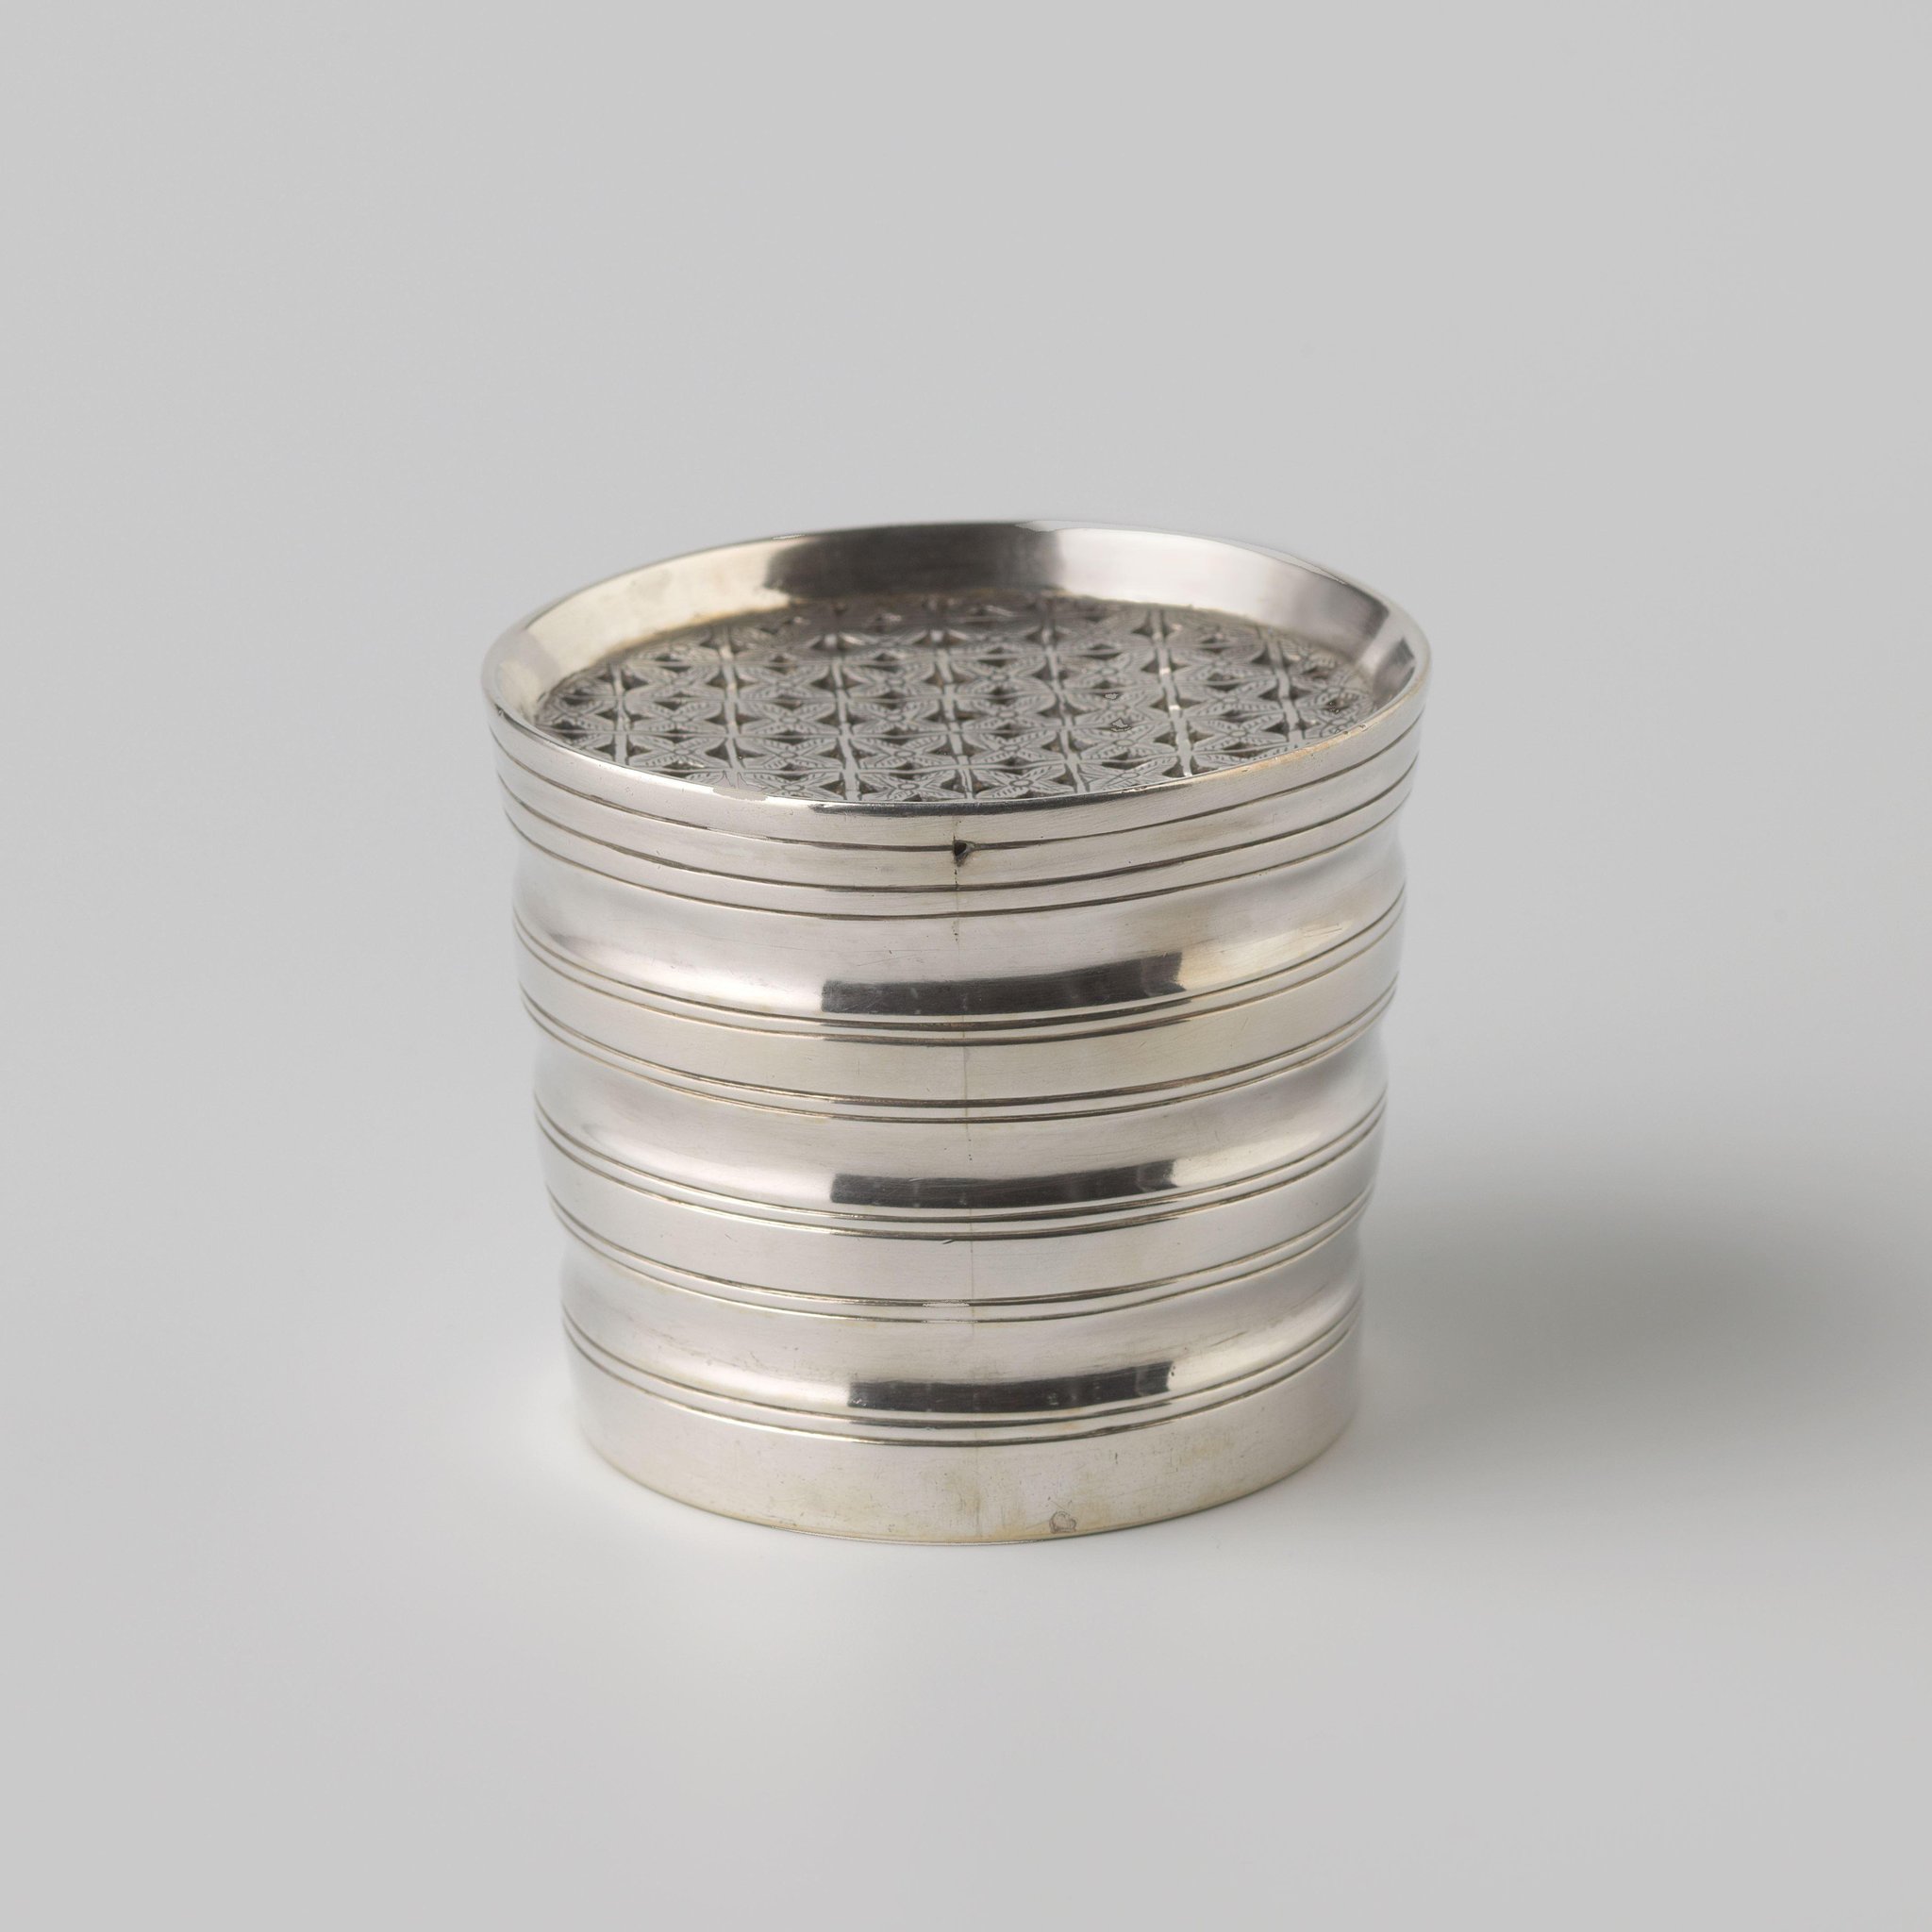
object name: sander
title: Zandstrooier van inktstel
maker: jurriaan van kalker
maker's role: goldsmith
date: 1725-1750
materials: silver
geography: jogjakarta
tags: batavia